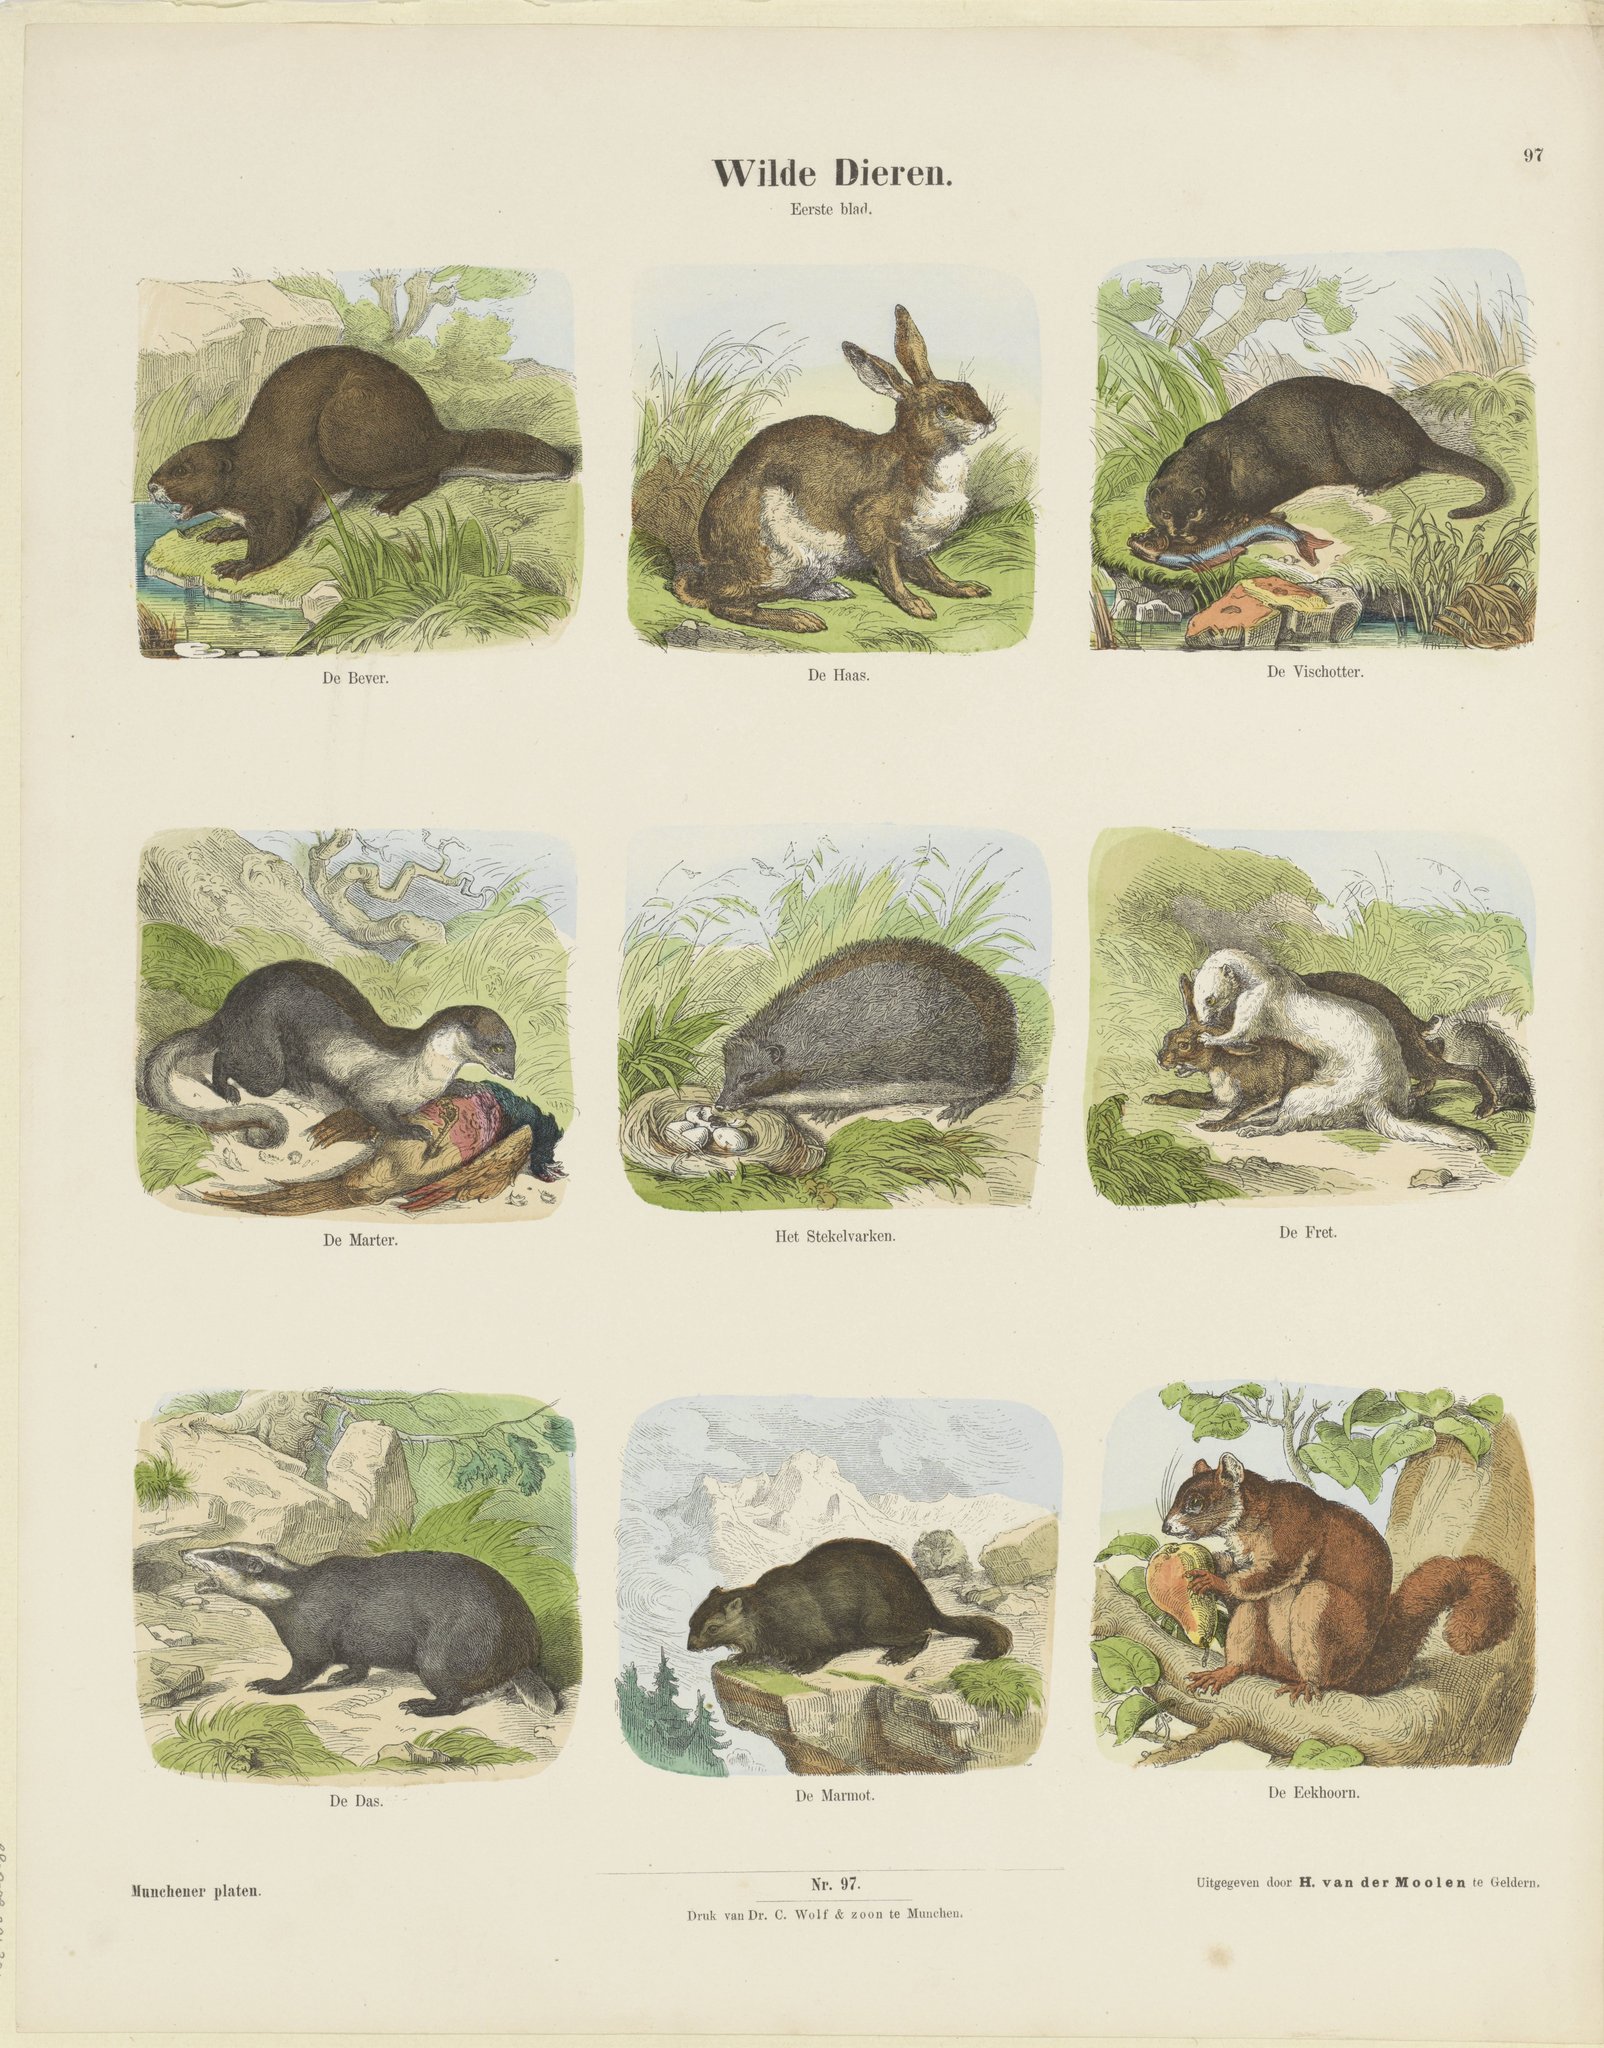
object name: popular print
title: Munchener platen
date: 1820-1843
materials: paper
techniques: colour, letterpress printing, engraving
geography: munich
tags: animals, rodents: hare, other mammals: hedgehog, rodents: squirrel, rodents: beaver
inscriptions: collector's mark: Lugt 2760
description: Blad met 9 voorstellingen van dieren, waaronder een bever, een haas, een otter, een egel en een eekhoorn. Onder elke afbeelding een onderschrift. Genummerd midden onder: Nro. 97. Genummerd rechtsboven: 97.